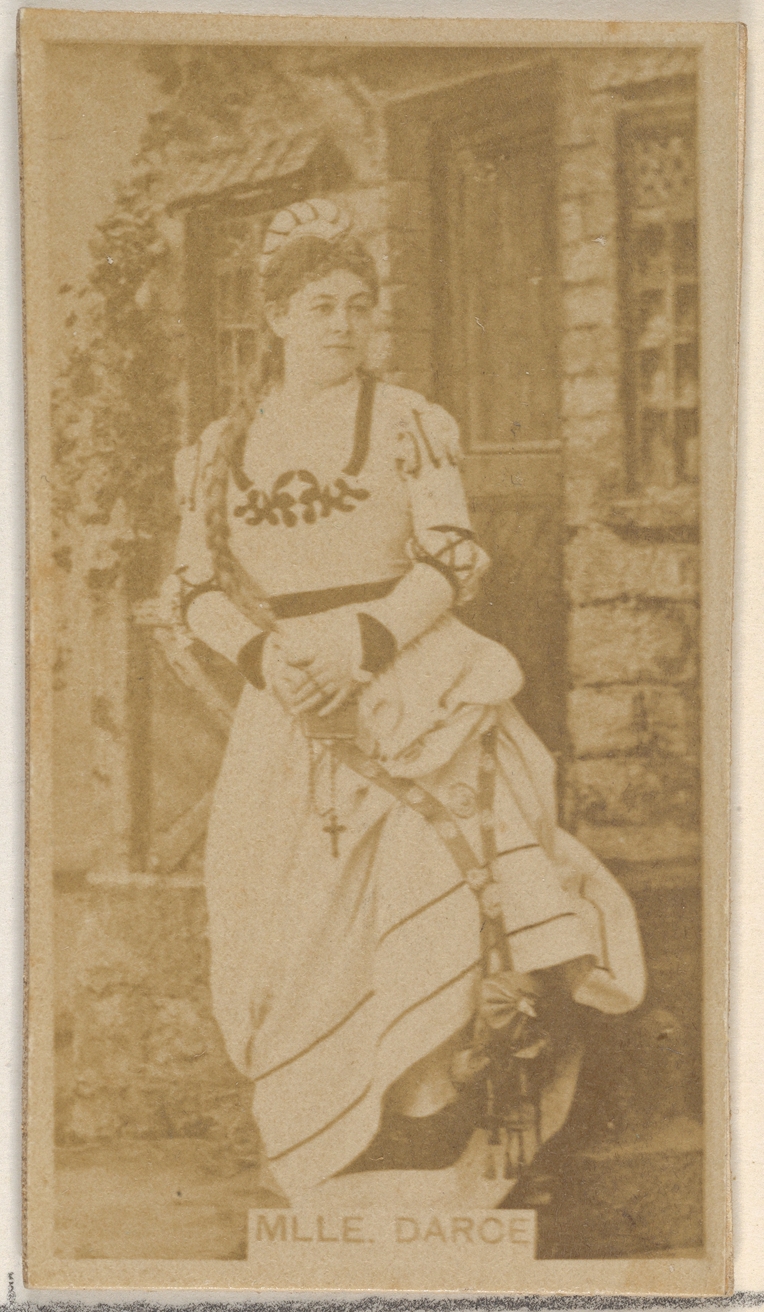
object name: photograph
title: Mlle. Darce, from the Actors and Actresses series (N45, Type 8) for Virginia Brights Cigarettes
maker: allen & ginter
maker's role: publisher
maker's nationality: american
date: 1888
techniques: albumen silver print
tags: portraits,women,actresses